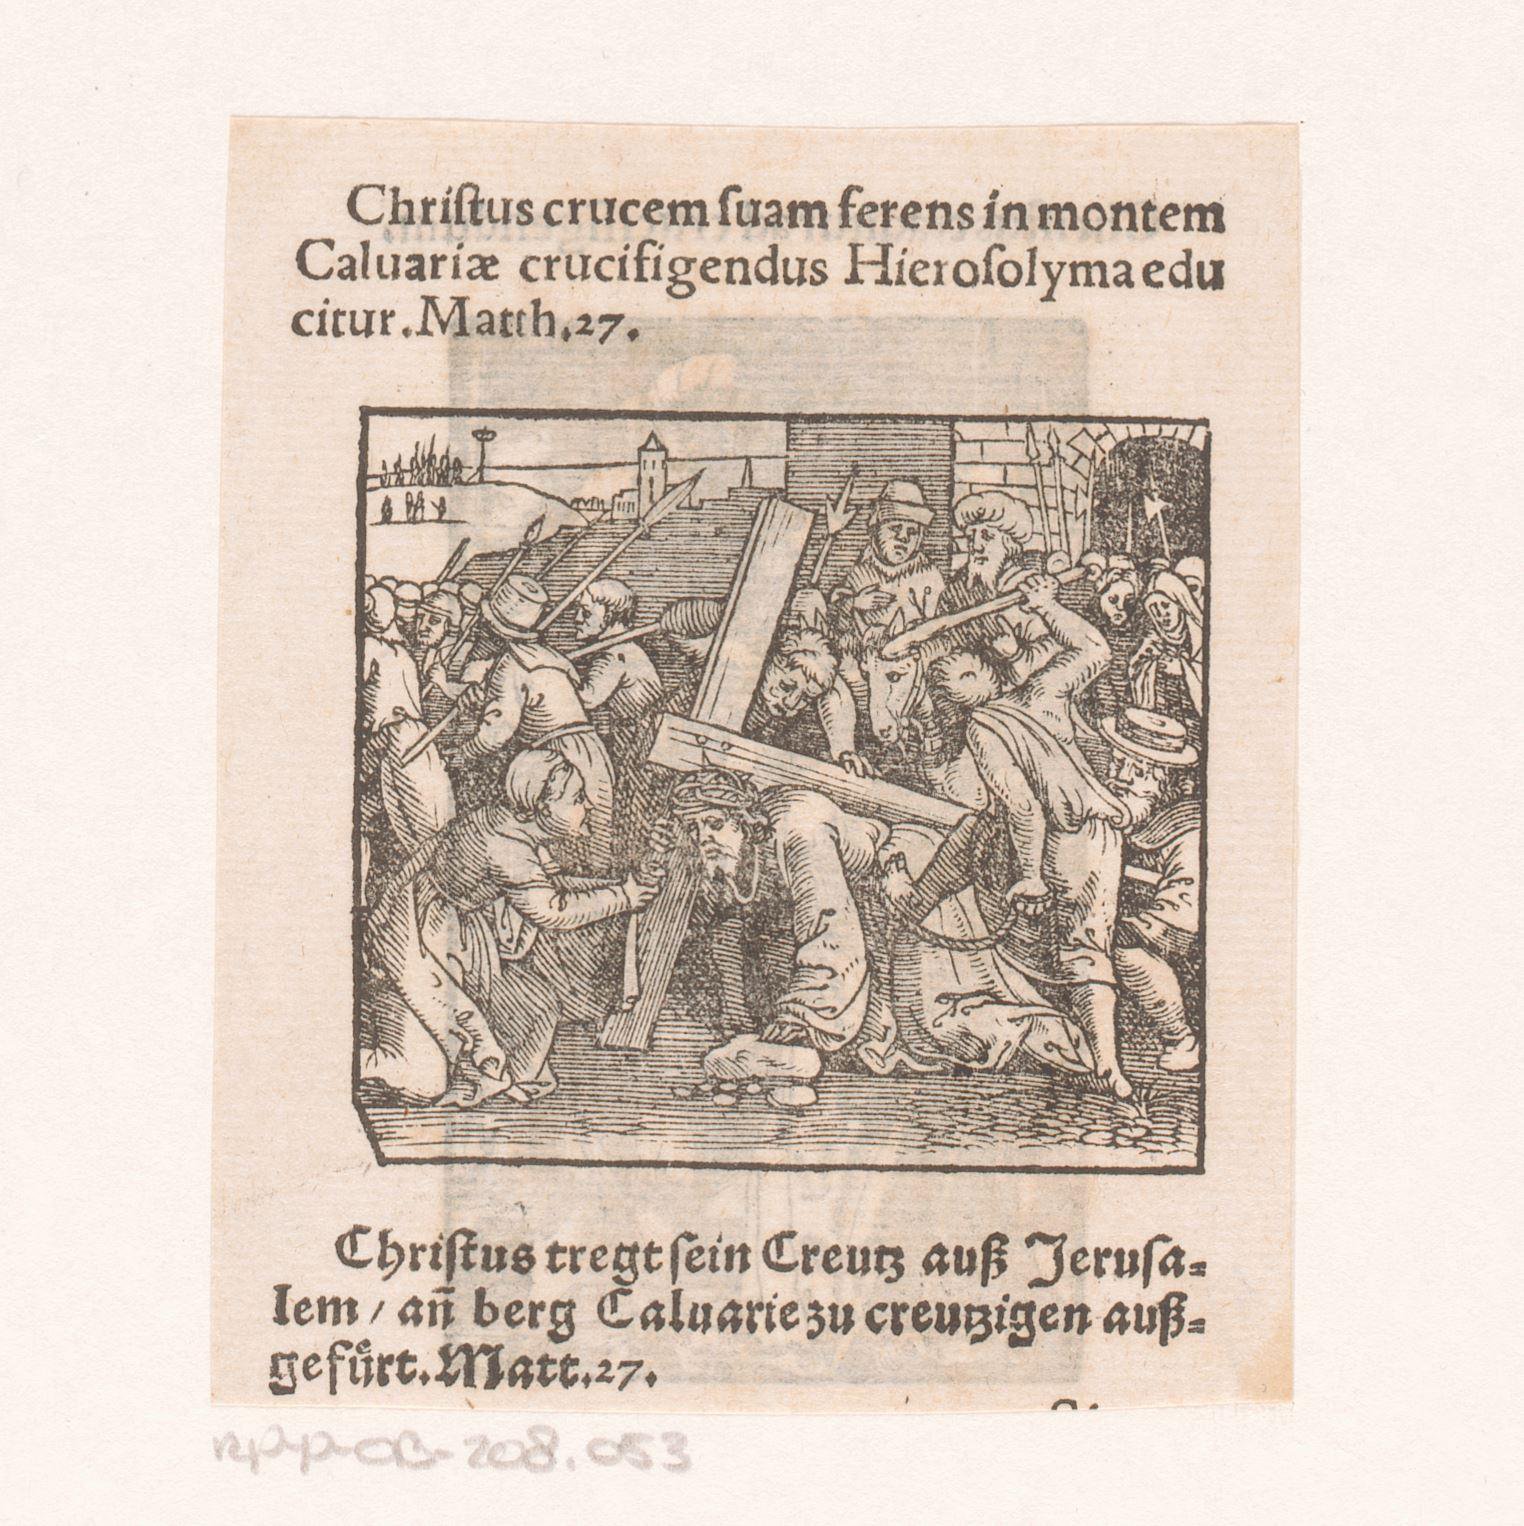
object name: book illustration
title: Ontmoeting van Christus met Veronica tijdens de kruisdraging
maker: Anonymous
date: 1600-1699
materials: paper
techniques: letterpress printing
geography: netherlands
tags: christ meets veronica, who has a cloth to wipe christ's face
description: Christus draagt het kruis en voor hem knielt Veronica om met haar doek het zweet van zijn gezicht te wissen.